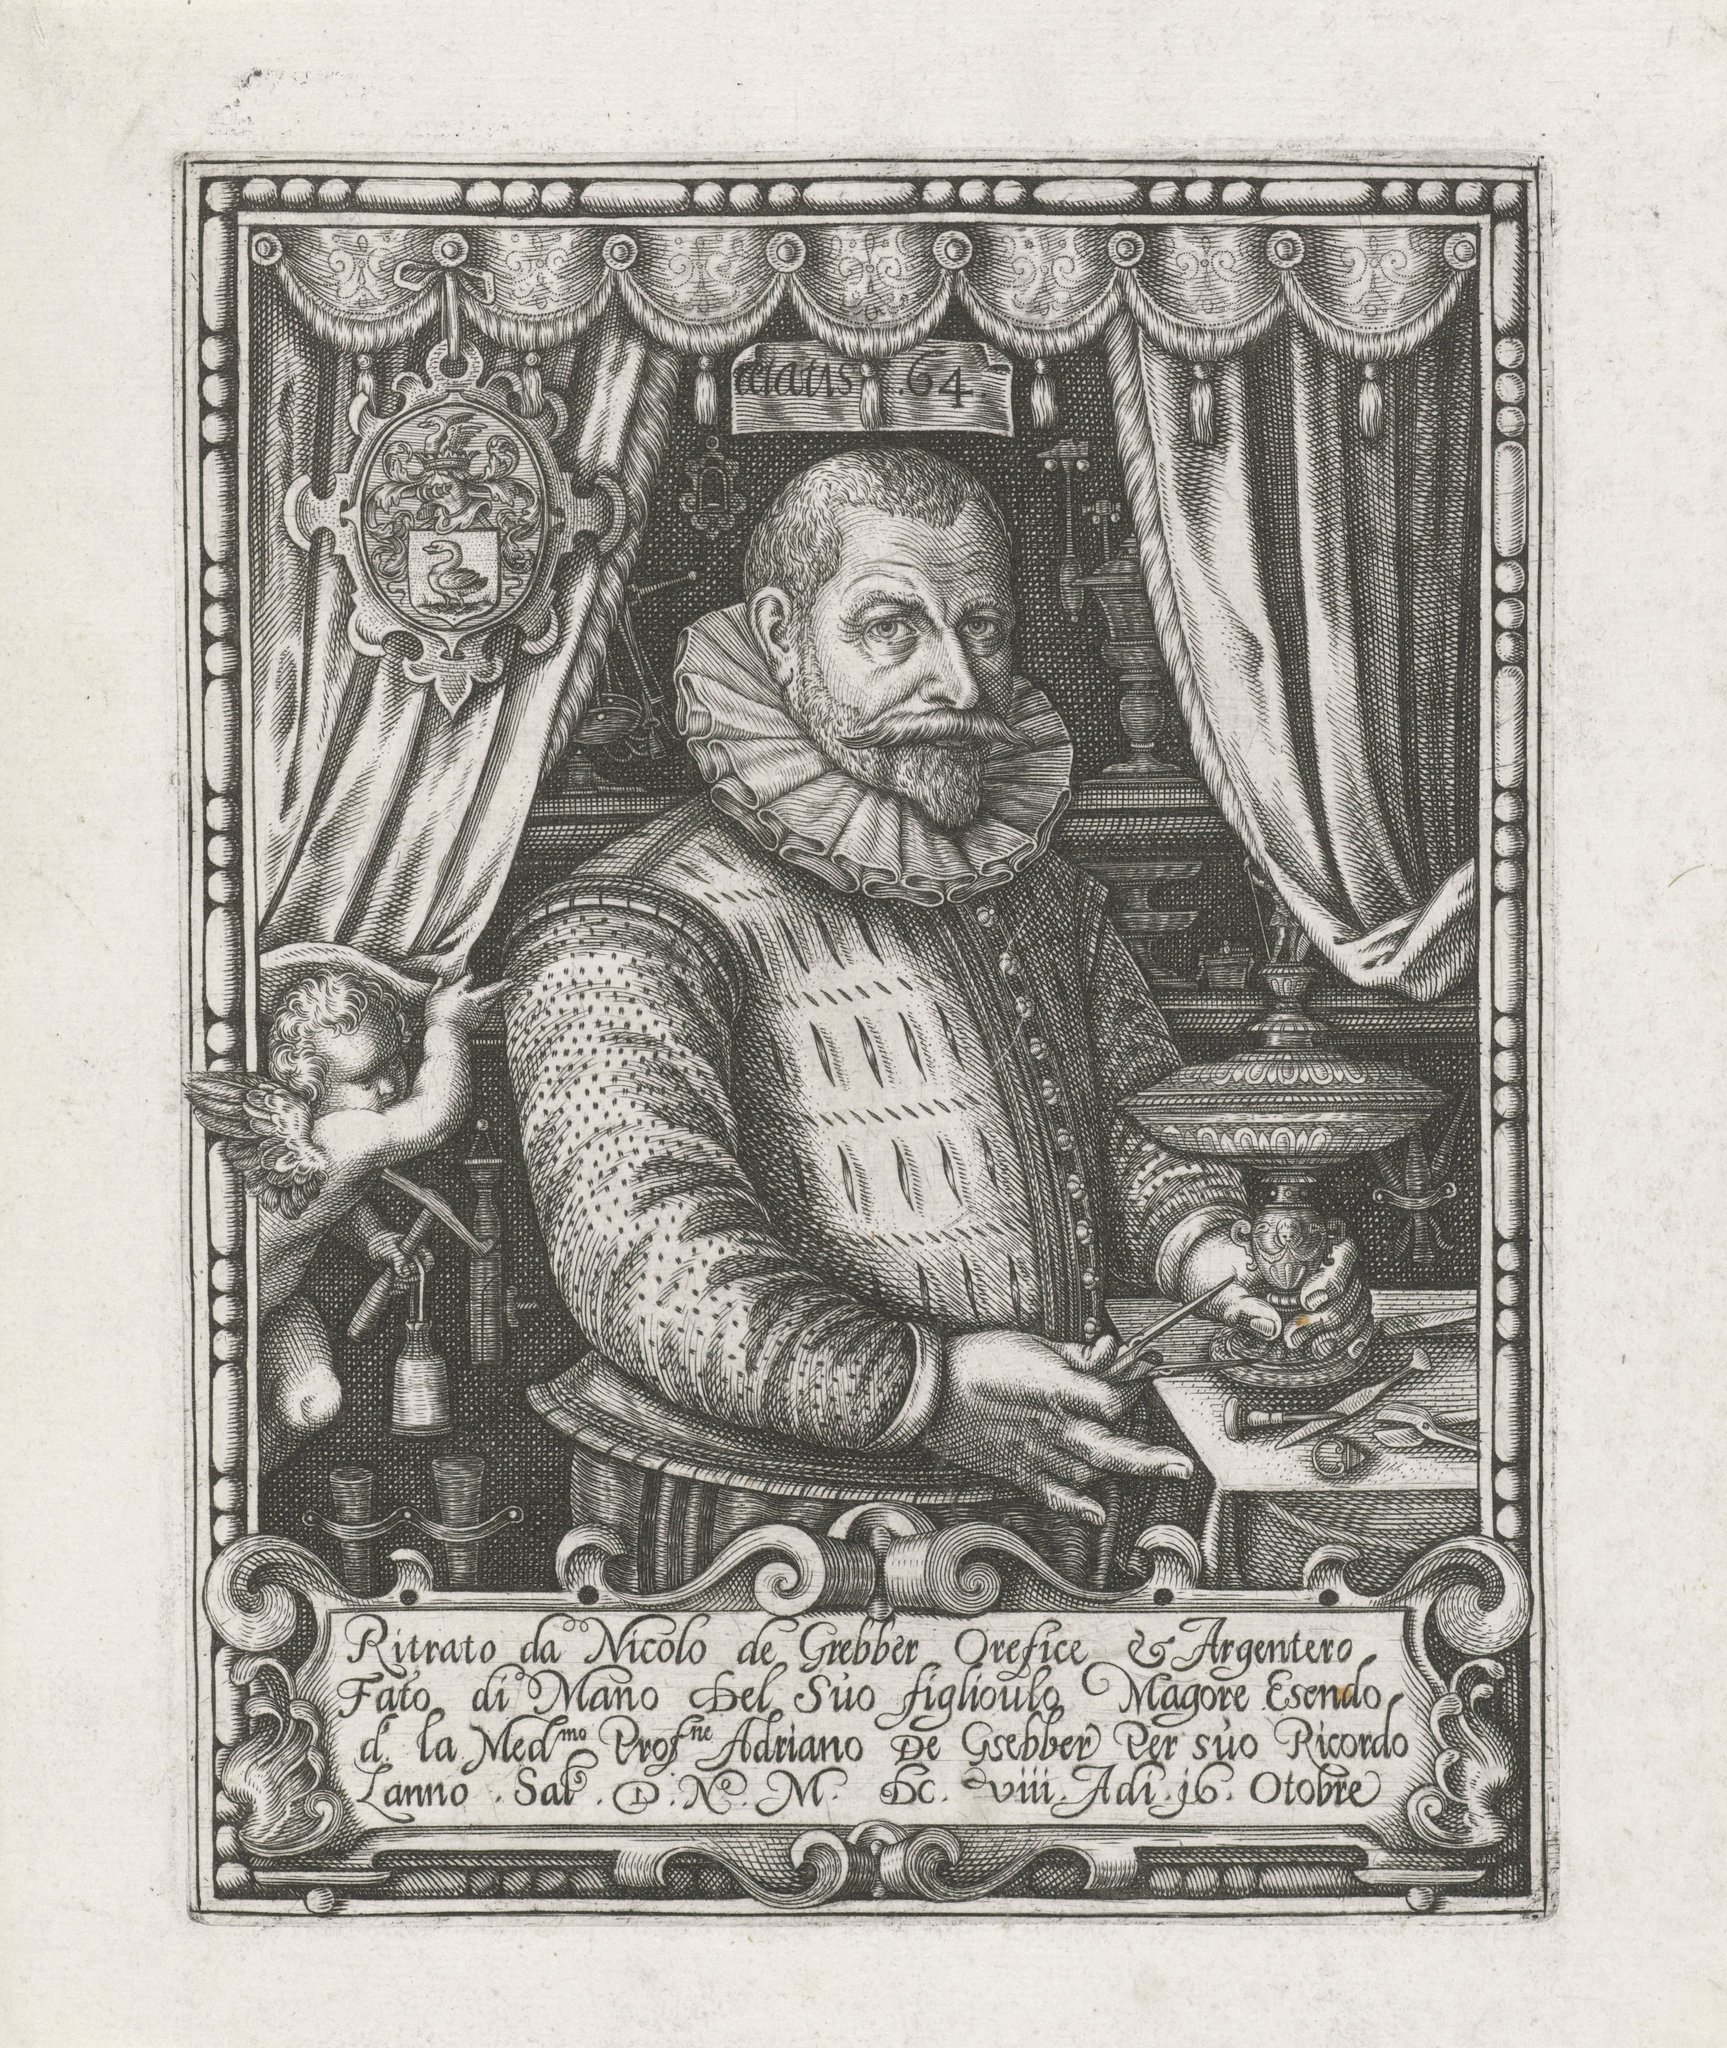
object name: print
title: Portret van Nicolaas de Grebber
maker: adriaen de grebber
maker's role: print maker, silversmith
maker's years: 1576-1661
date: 1608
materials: paper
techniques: engraving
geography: haarlem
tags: jeweller, goldsmith, silversmith (+ artist at work)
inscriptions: collector's mark: Lugt 2228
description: Portret van Nicolaas de Grebber op 64-jarige leeftijd. De Grebber was een goudsmid uit Haarlem en de vader van de prentmaker. De man heeft de instrumenten van een goudsmid vast en werkt aan een beker. De prent heeft een Italiaans onderschrift.